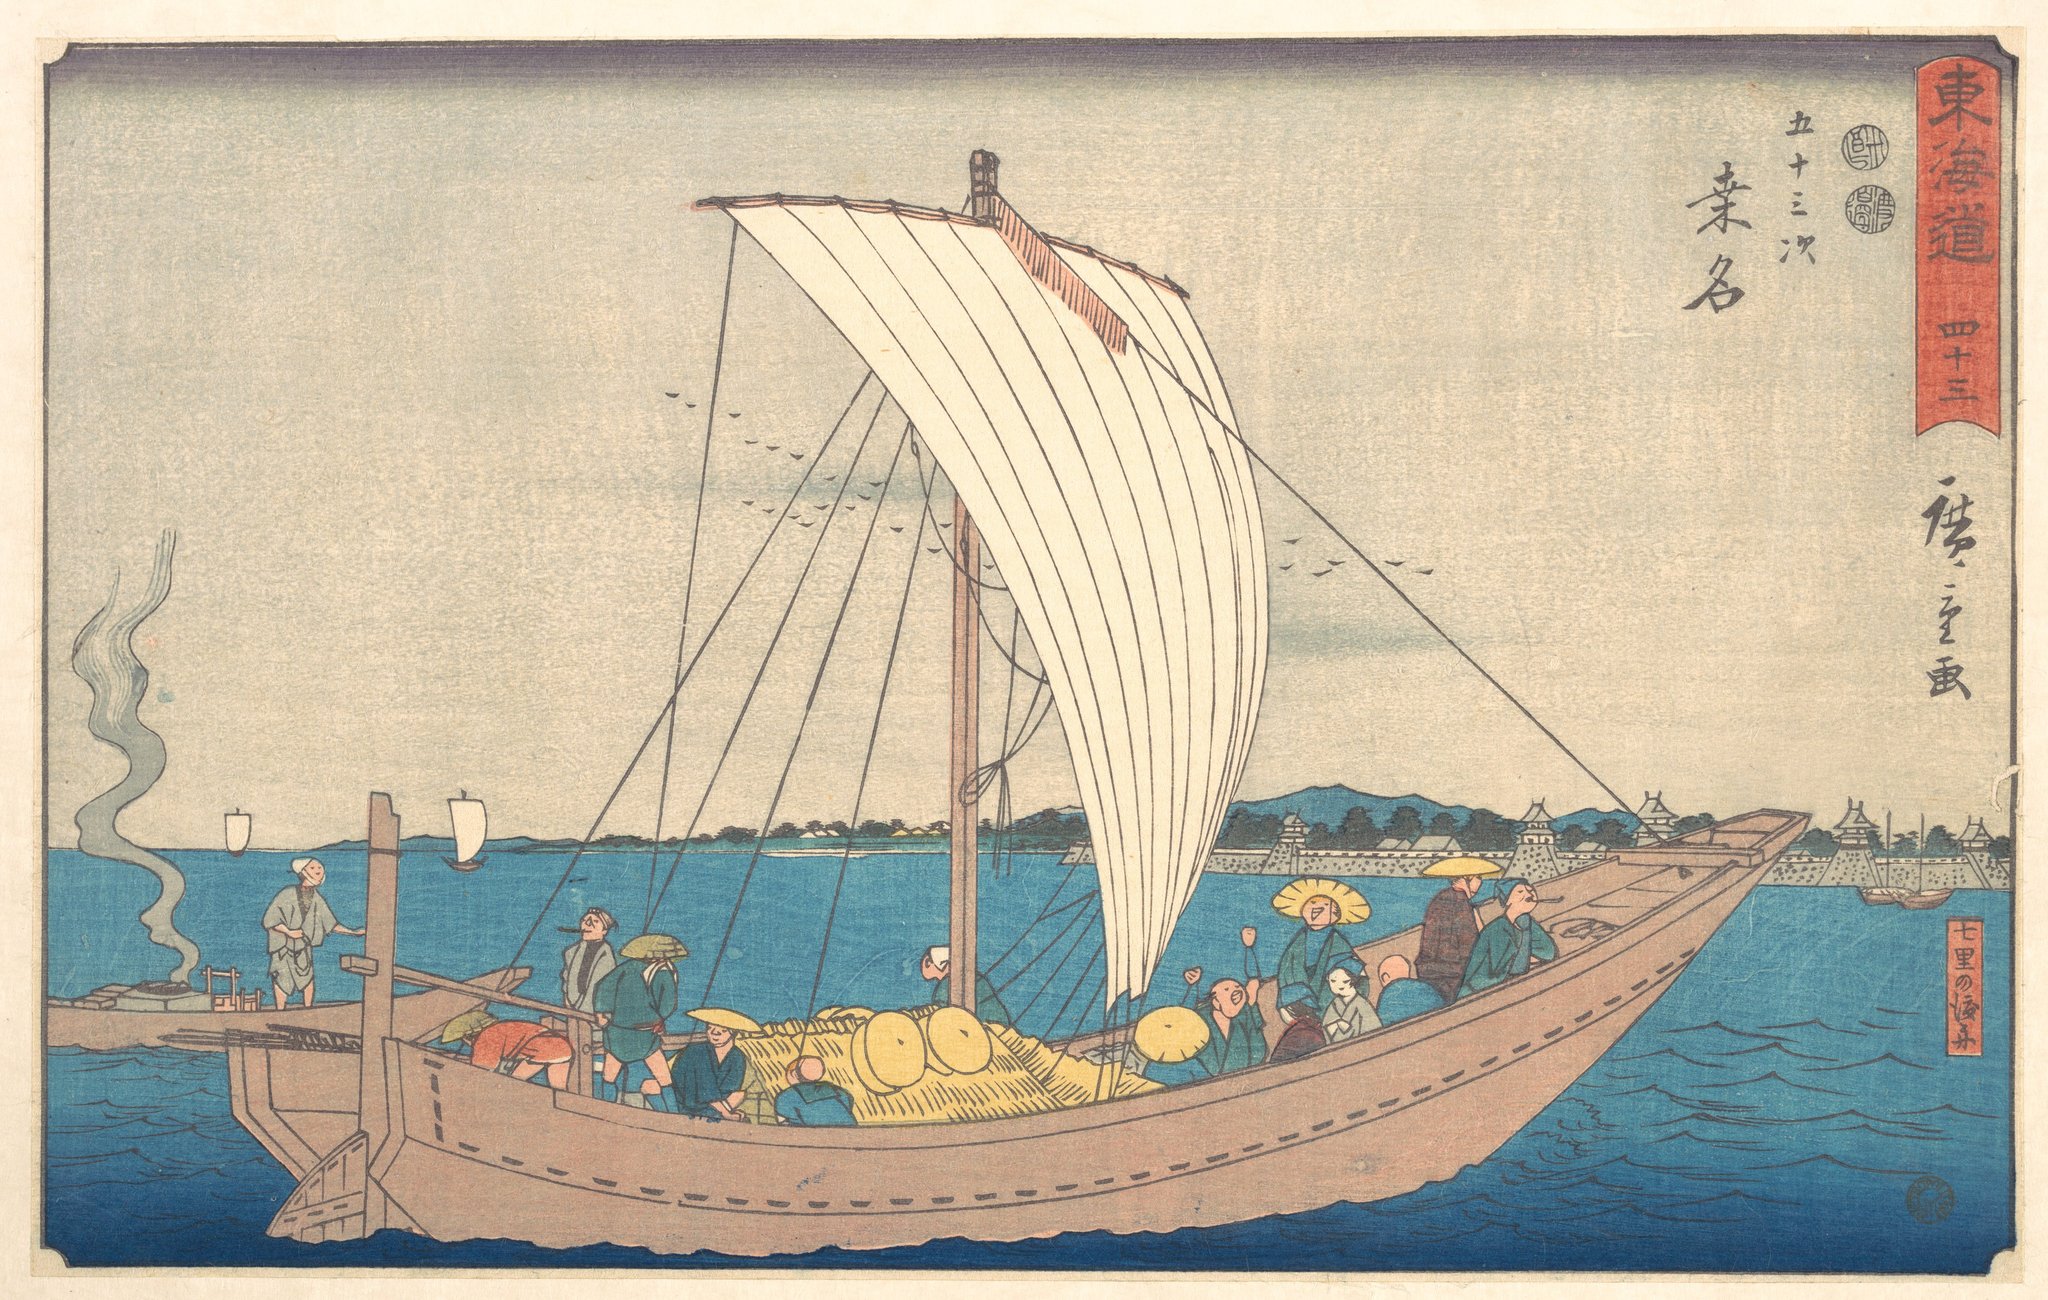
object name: print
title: Kuwana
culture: japanese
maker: utagawa hiroshige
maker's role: artist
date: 1840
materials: ink, paper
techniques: woodblock print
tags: human figures,boats